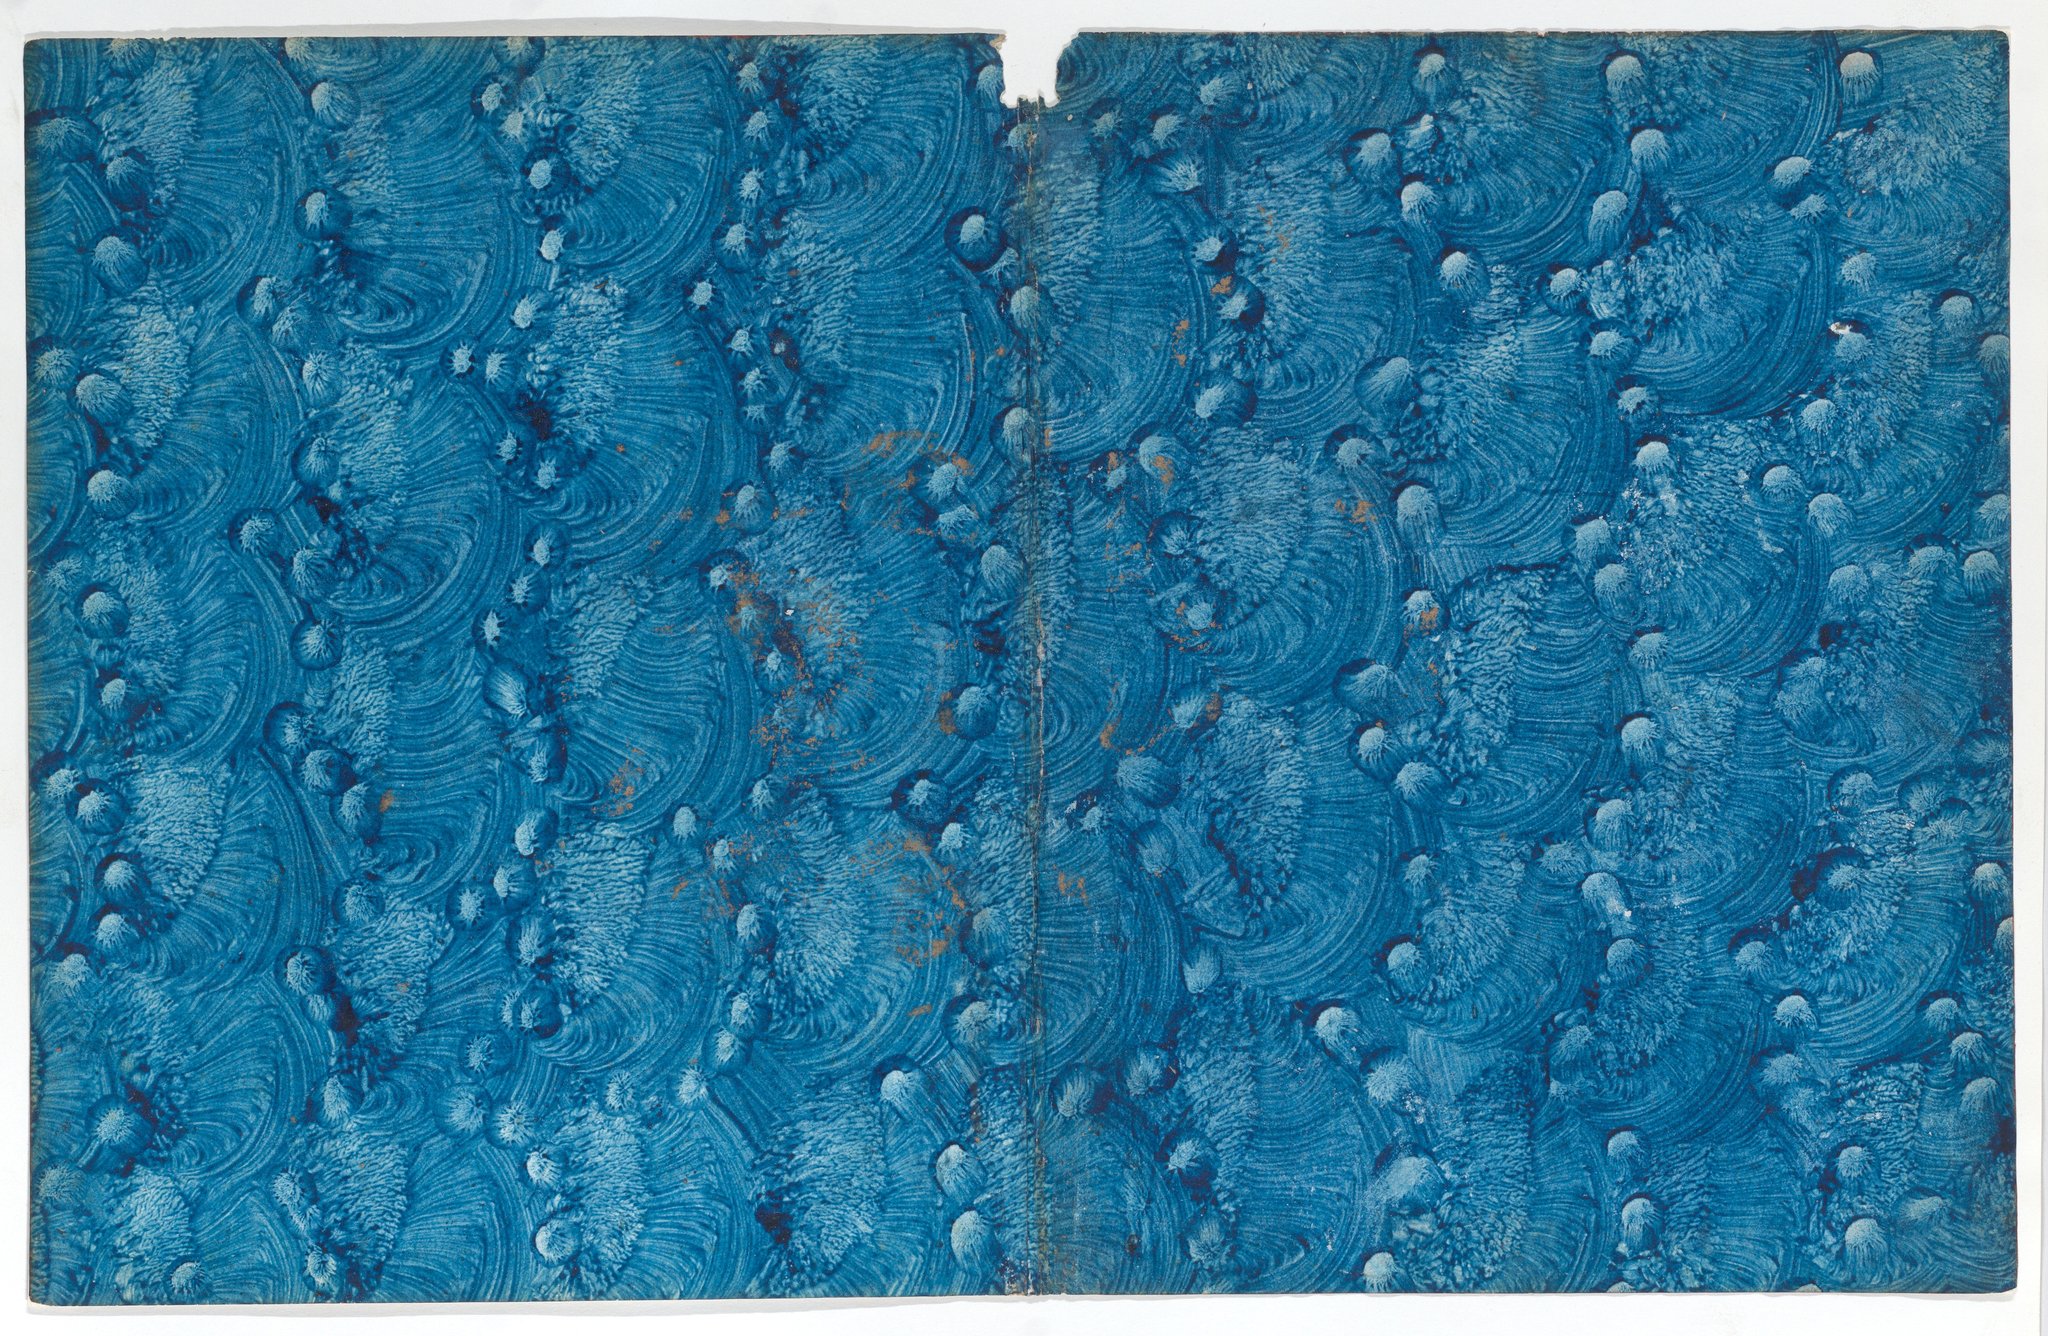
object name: print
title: Book cover with curved blue pattern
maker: Anonymous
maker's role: artist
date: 1801-1900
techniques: relief print